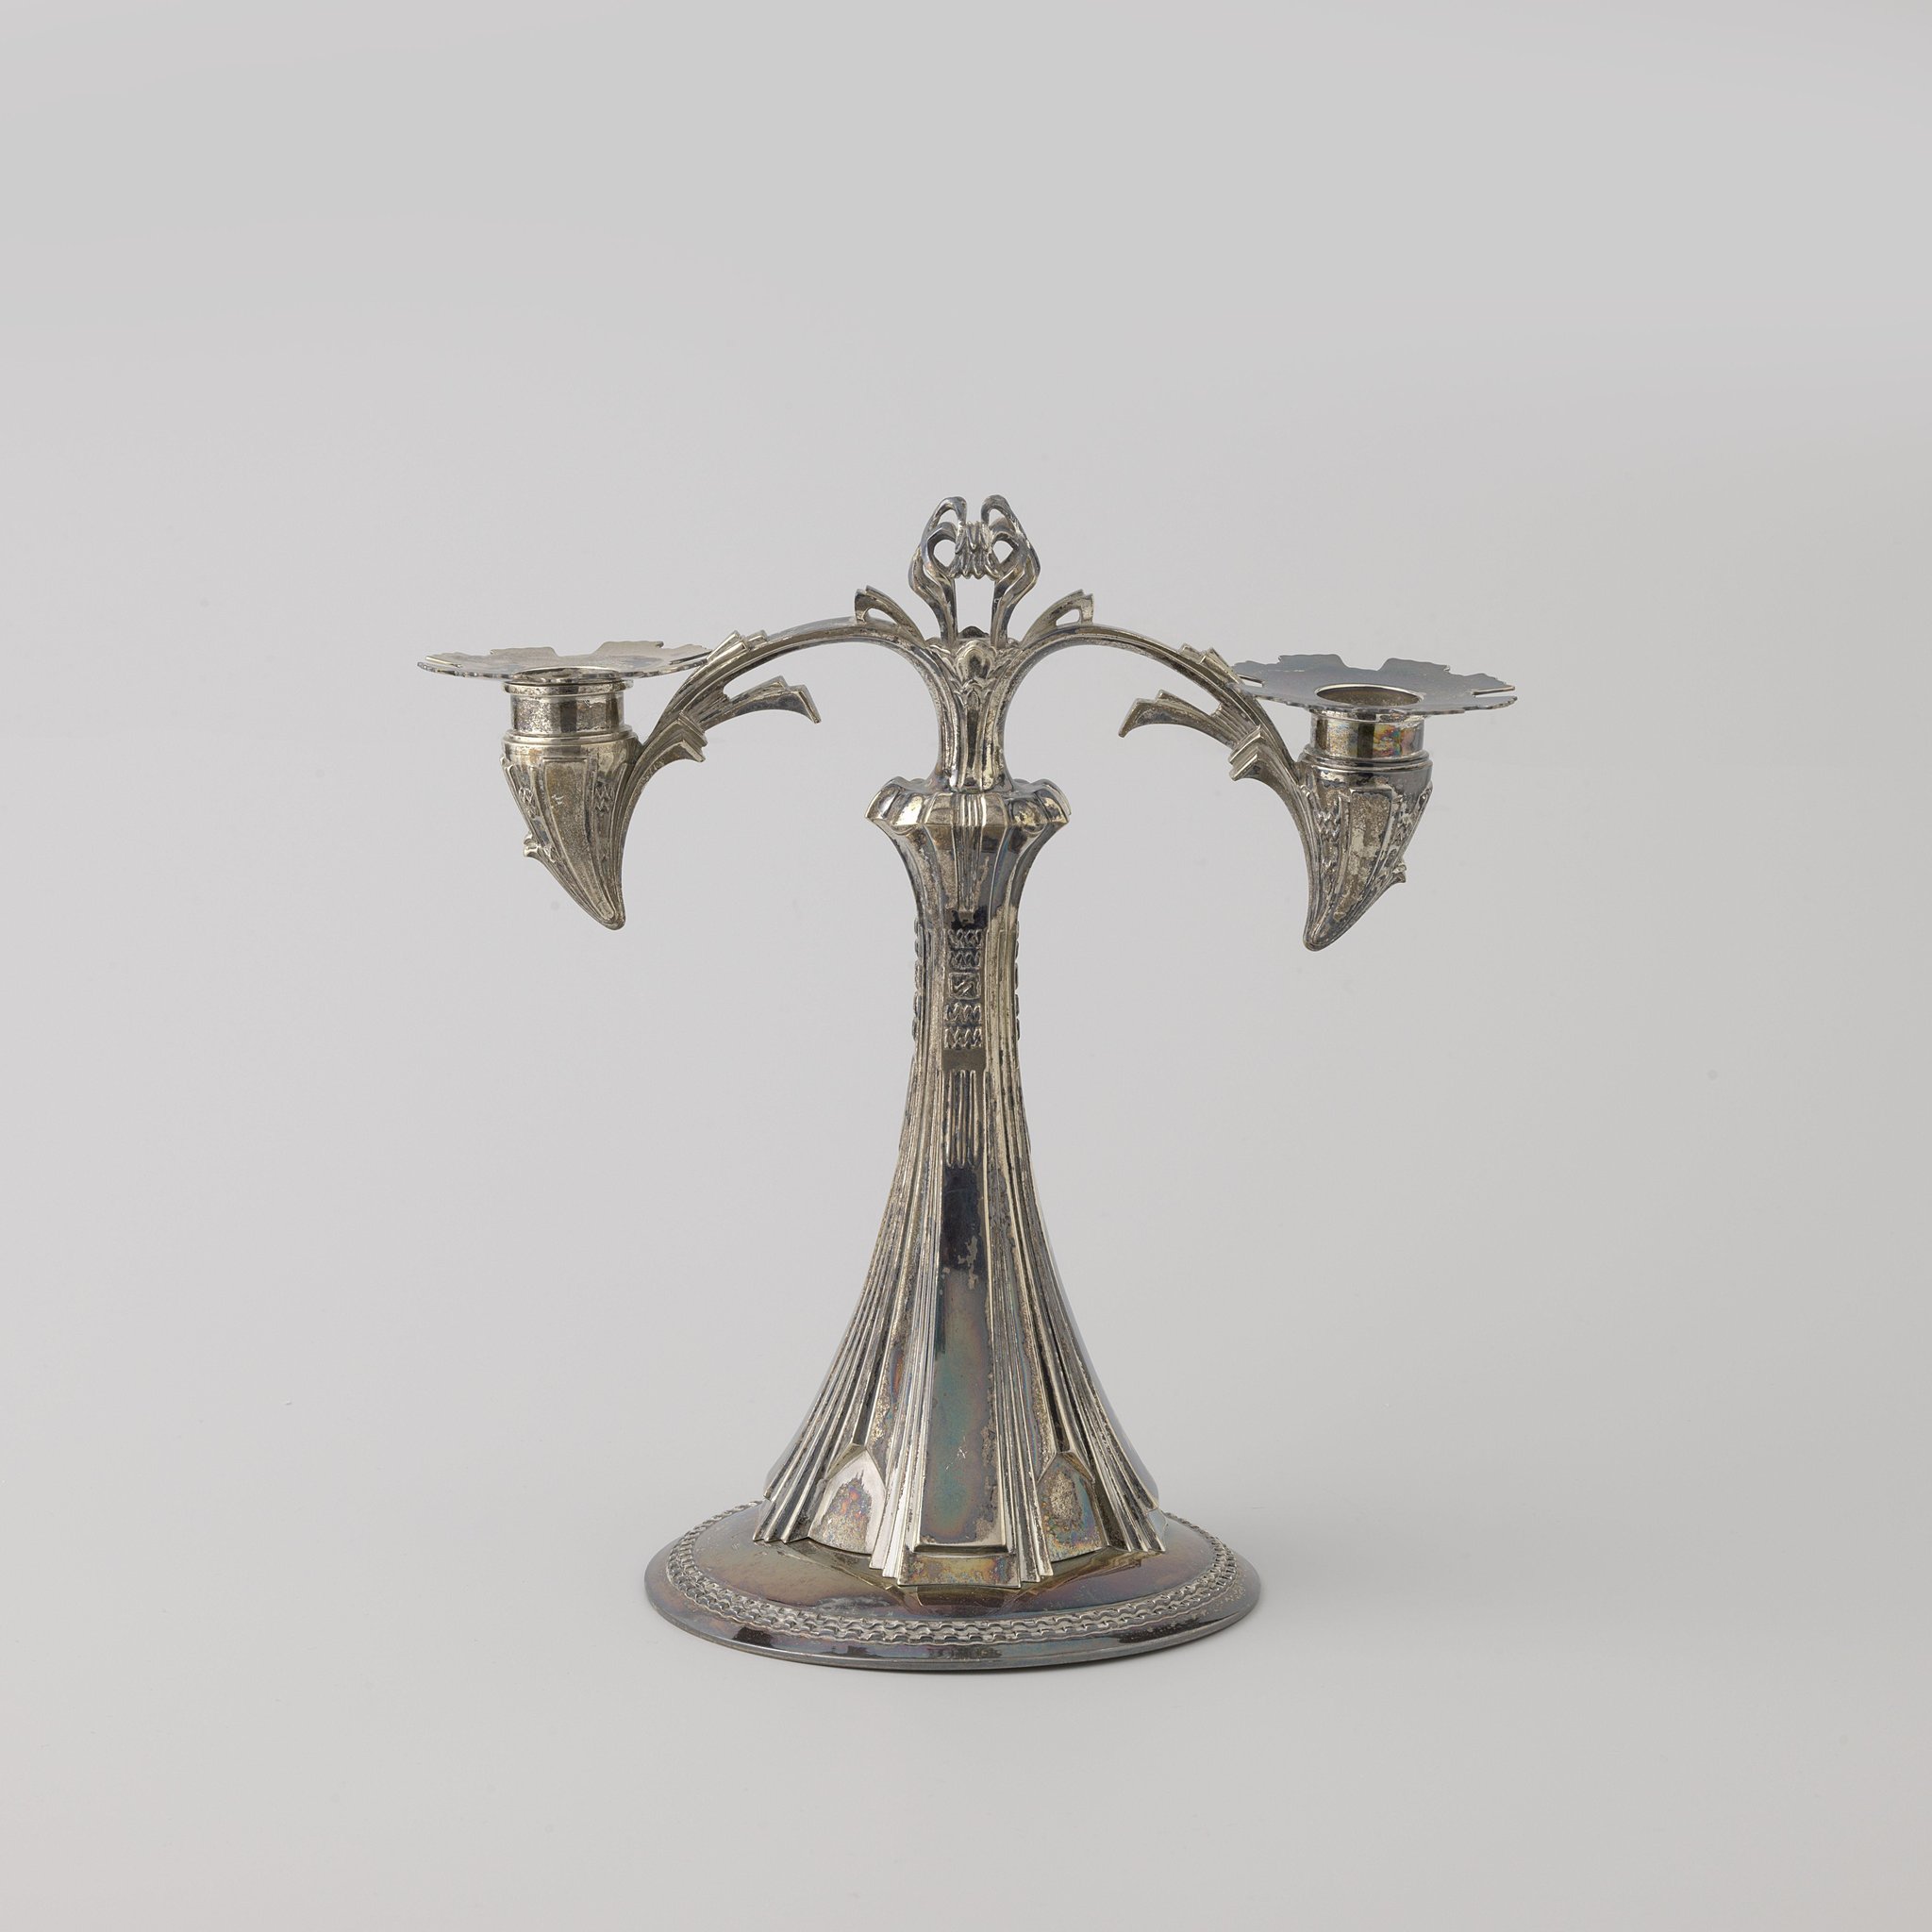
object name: candelabrum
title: Kandelaber op ronde voet. Uit de stam ontspringen twee gebogen armen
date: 1905-1920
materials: silver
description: Two candelabra. Silver. Vienna, c. 1905 - 1920, by J.C. Klinkosch.